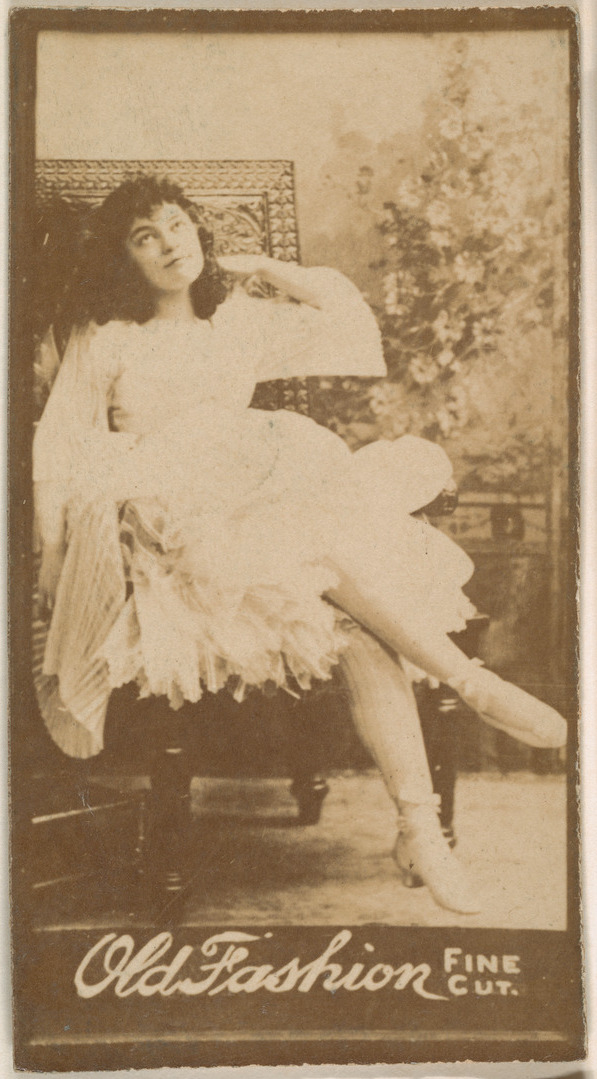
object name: photograph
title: Actress seated in chair, from the Actresses series (N664) promoting Old Fashion Fine Cut Tobacco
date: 1888-1890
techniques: albumen silver print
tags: portraits,women,actresses